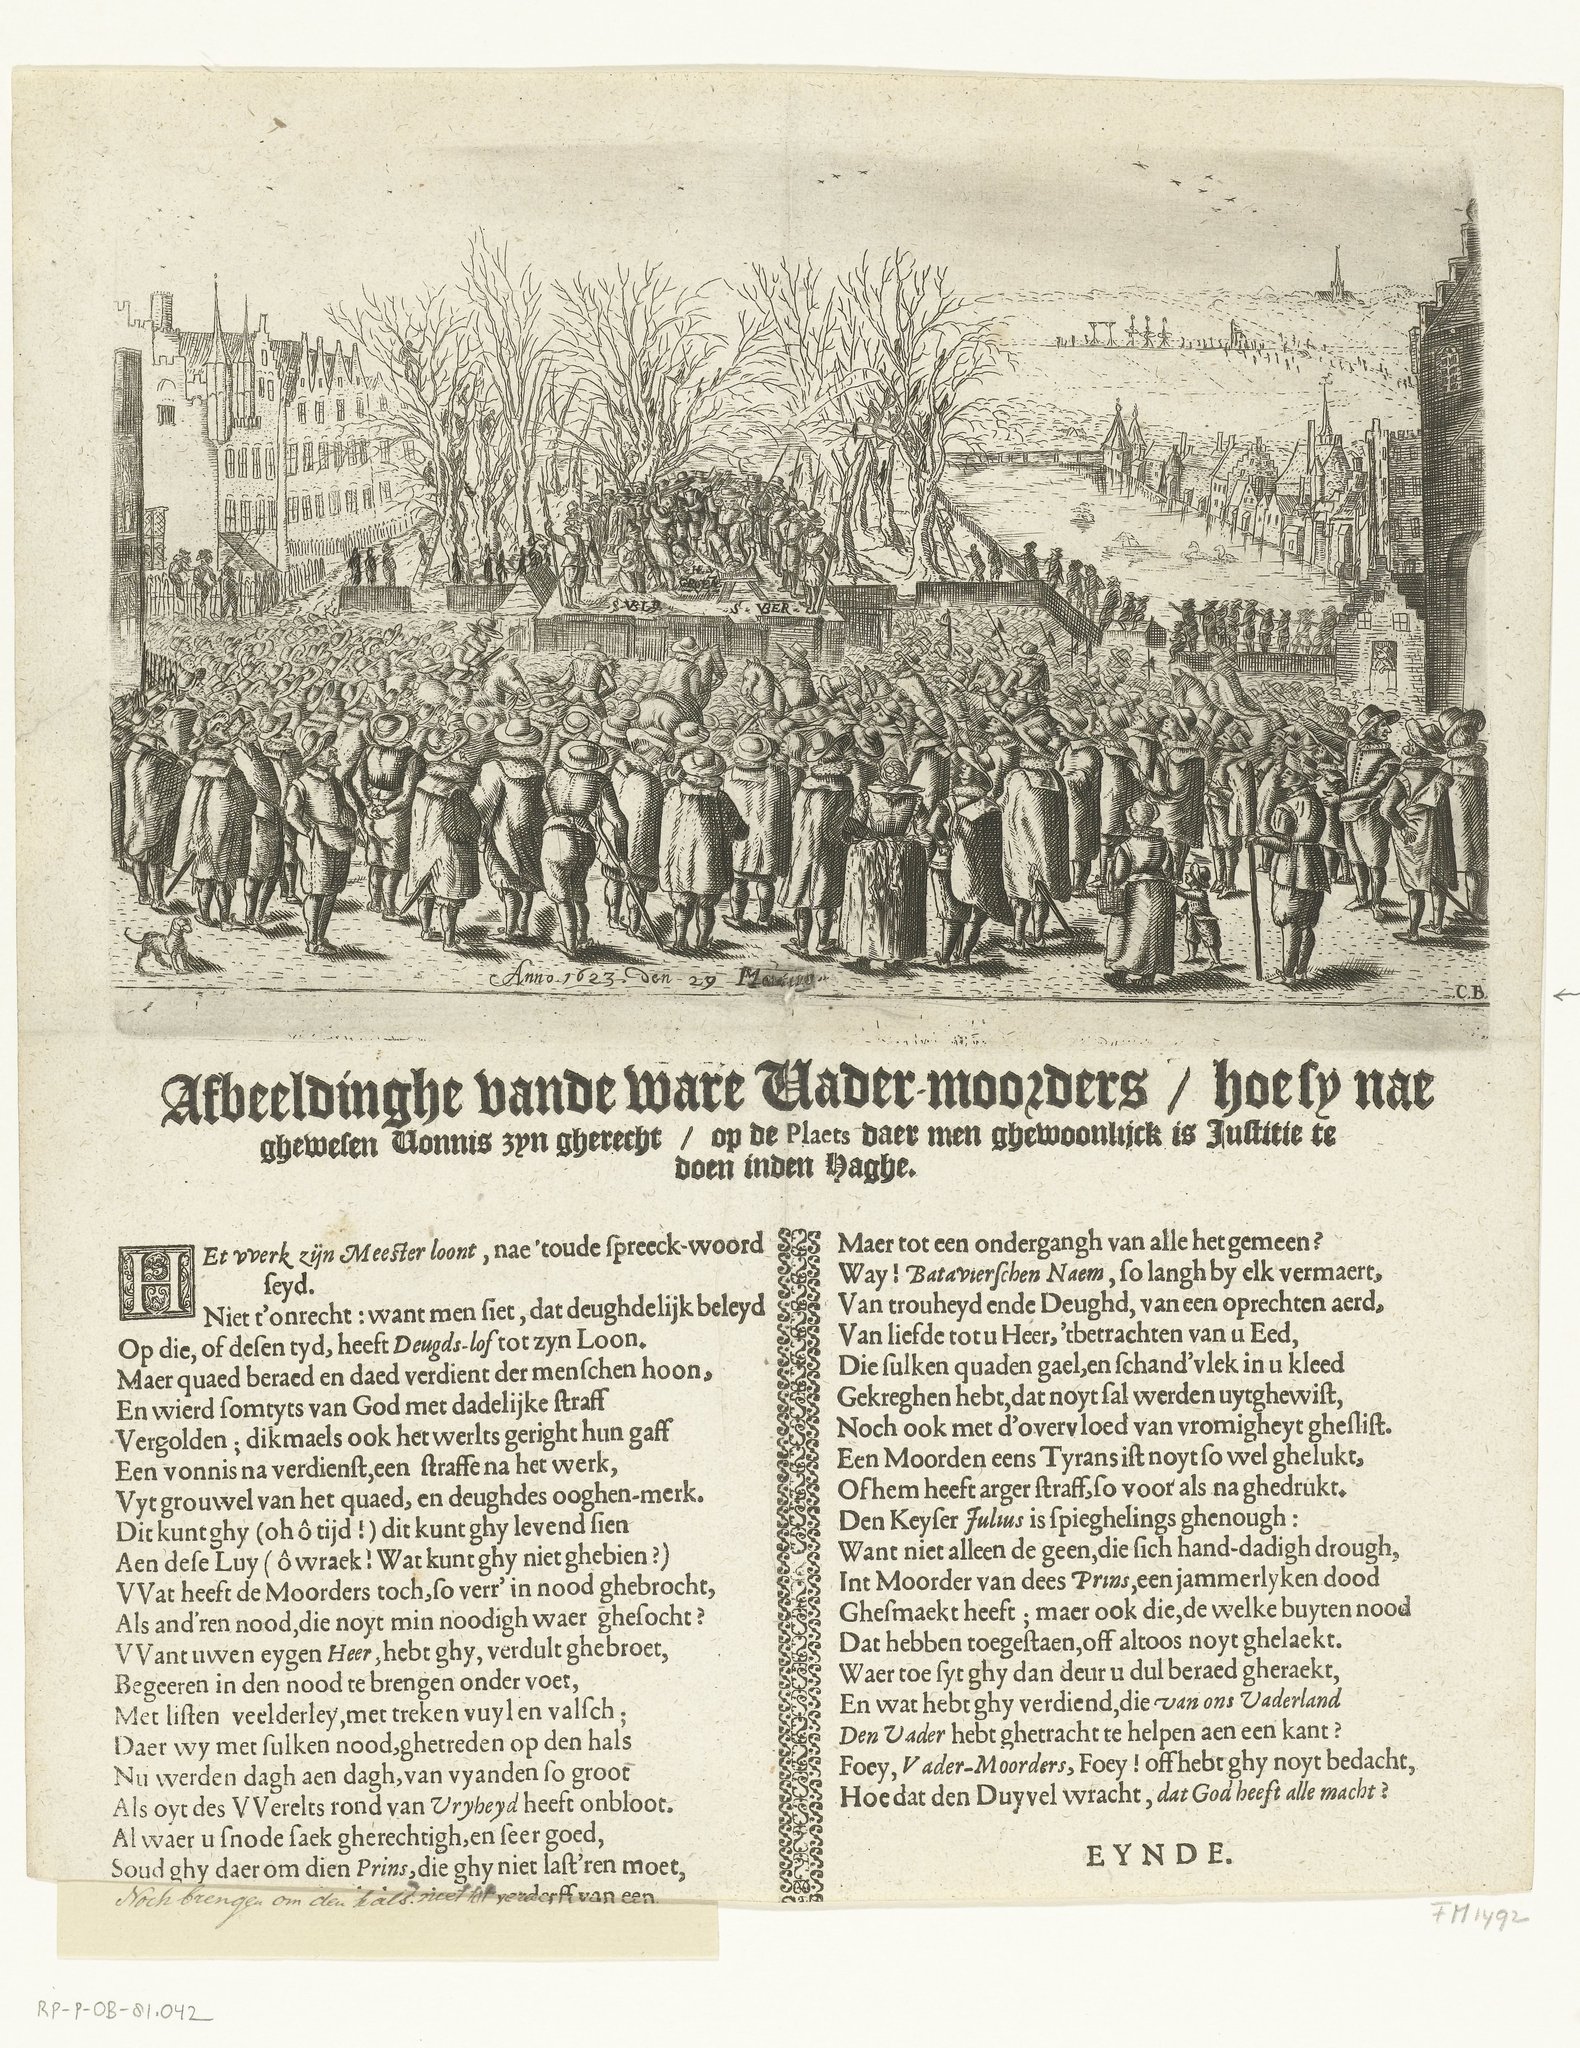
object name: print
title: Executie van Reinier van Oldenbarnevelt, David Coorenwinder en Adriaan van Dijk, 1623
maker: cornelis willemsz blaeu-laken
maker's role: publisher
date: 1623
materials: paper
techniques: engraving, etching, letterpress printing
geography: northern netherlands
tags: the hague, maurice (prince of orange), (revolutionary) plot, conspiracy, on the scaffold or place of execution, mutilation of the corpse, violent death by beheading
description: De executies van Reinier van Oldenbarnevelt, David Coorenwinder en Adriaan van Dijk, 29 maart 1623, op het schavot op het Groene Zoodje te Den Haag. Met een grote menigte toeschouwers. Onder de plaat een vers in 2 kolommen in het Nederlands.